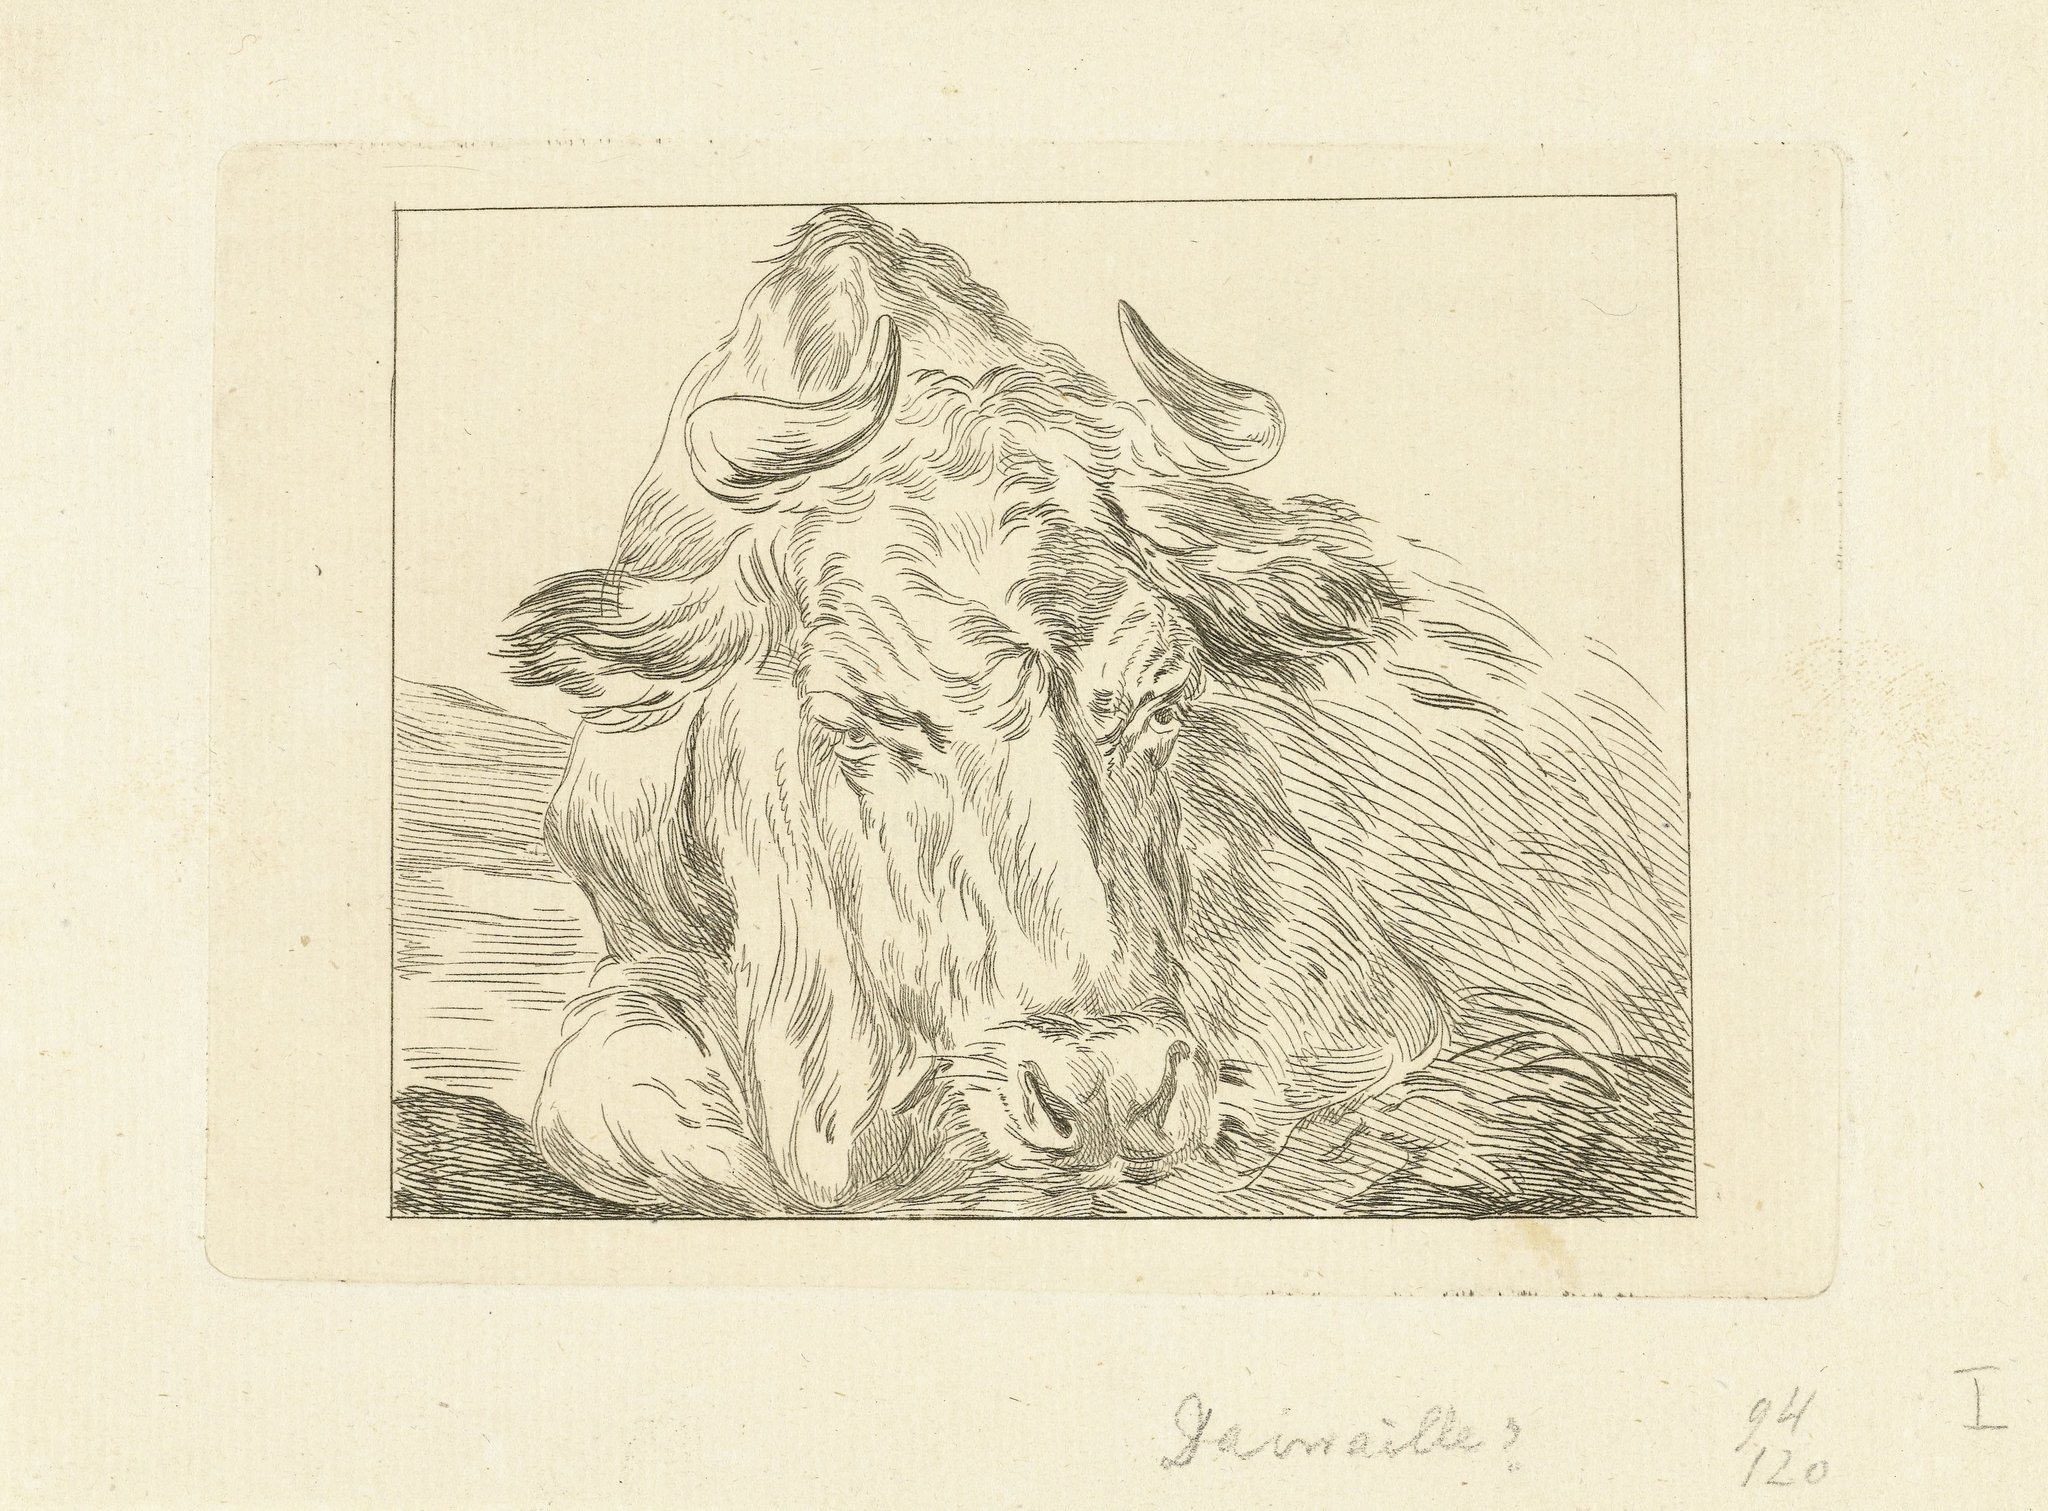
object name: print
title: Liggende koe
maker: jean augustin daiwaille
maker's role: draughtsman, print maker, printer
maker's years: 1786-1850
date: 1796-1850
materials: paper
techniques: etching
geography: netherlands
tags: cow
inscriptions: collector's mark: Lugt 2228